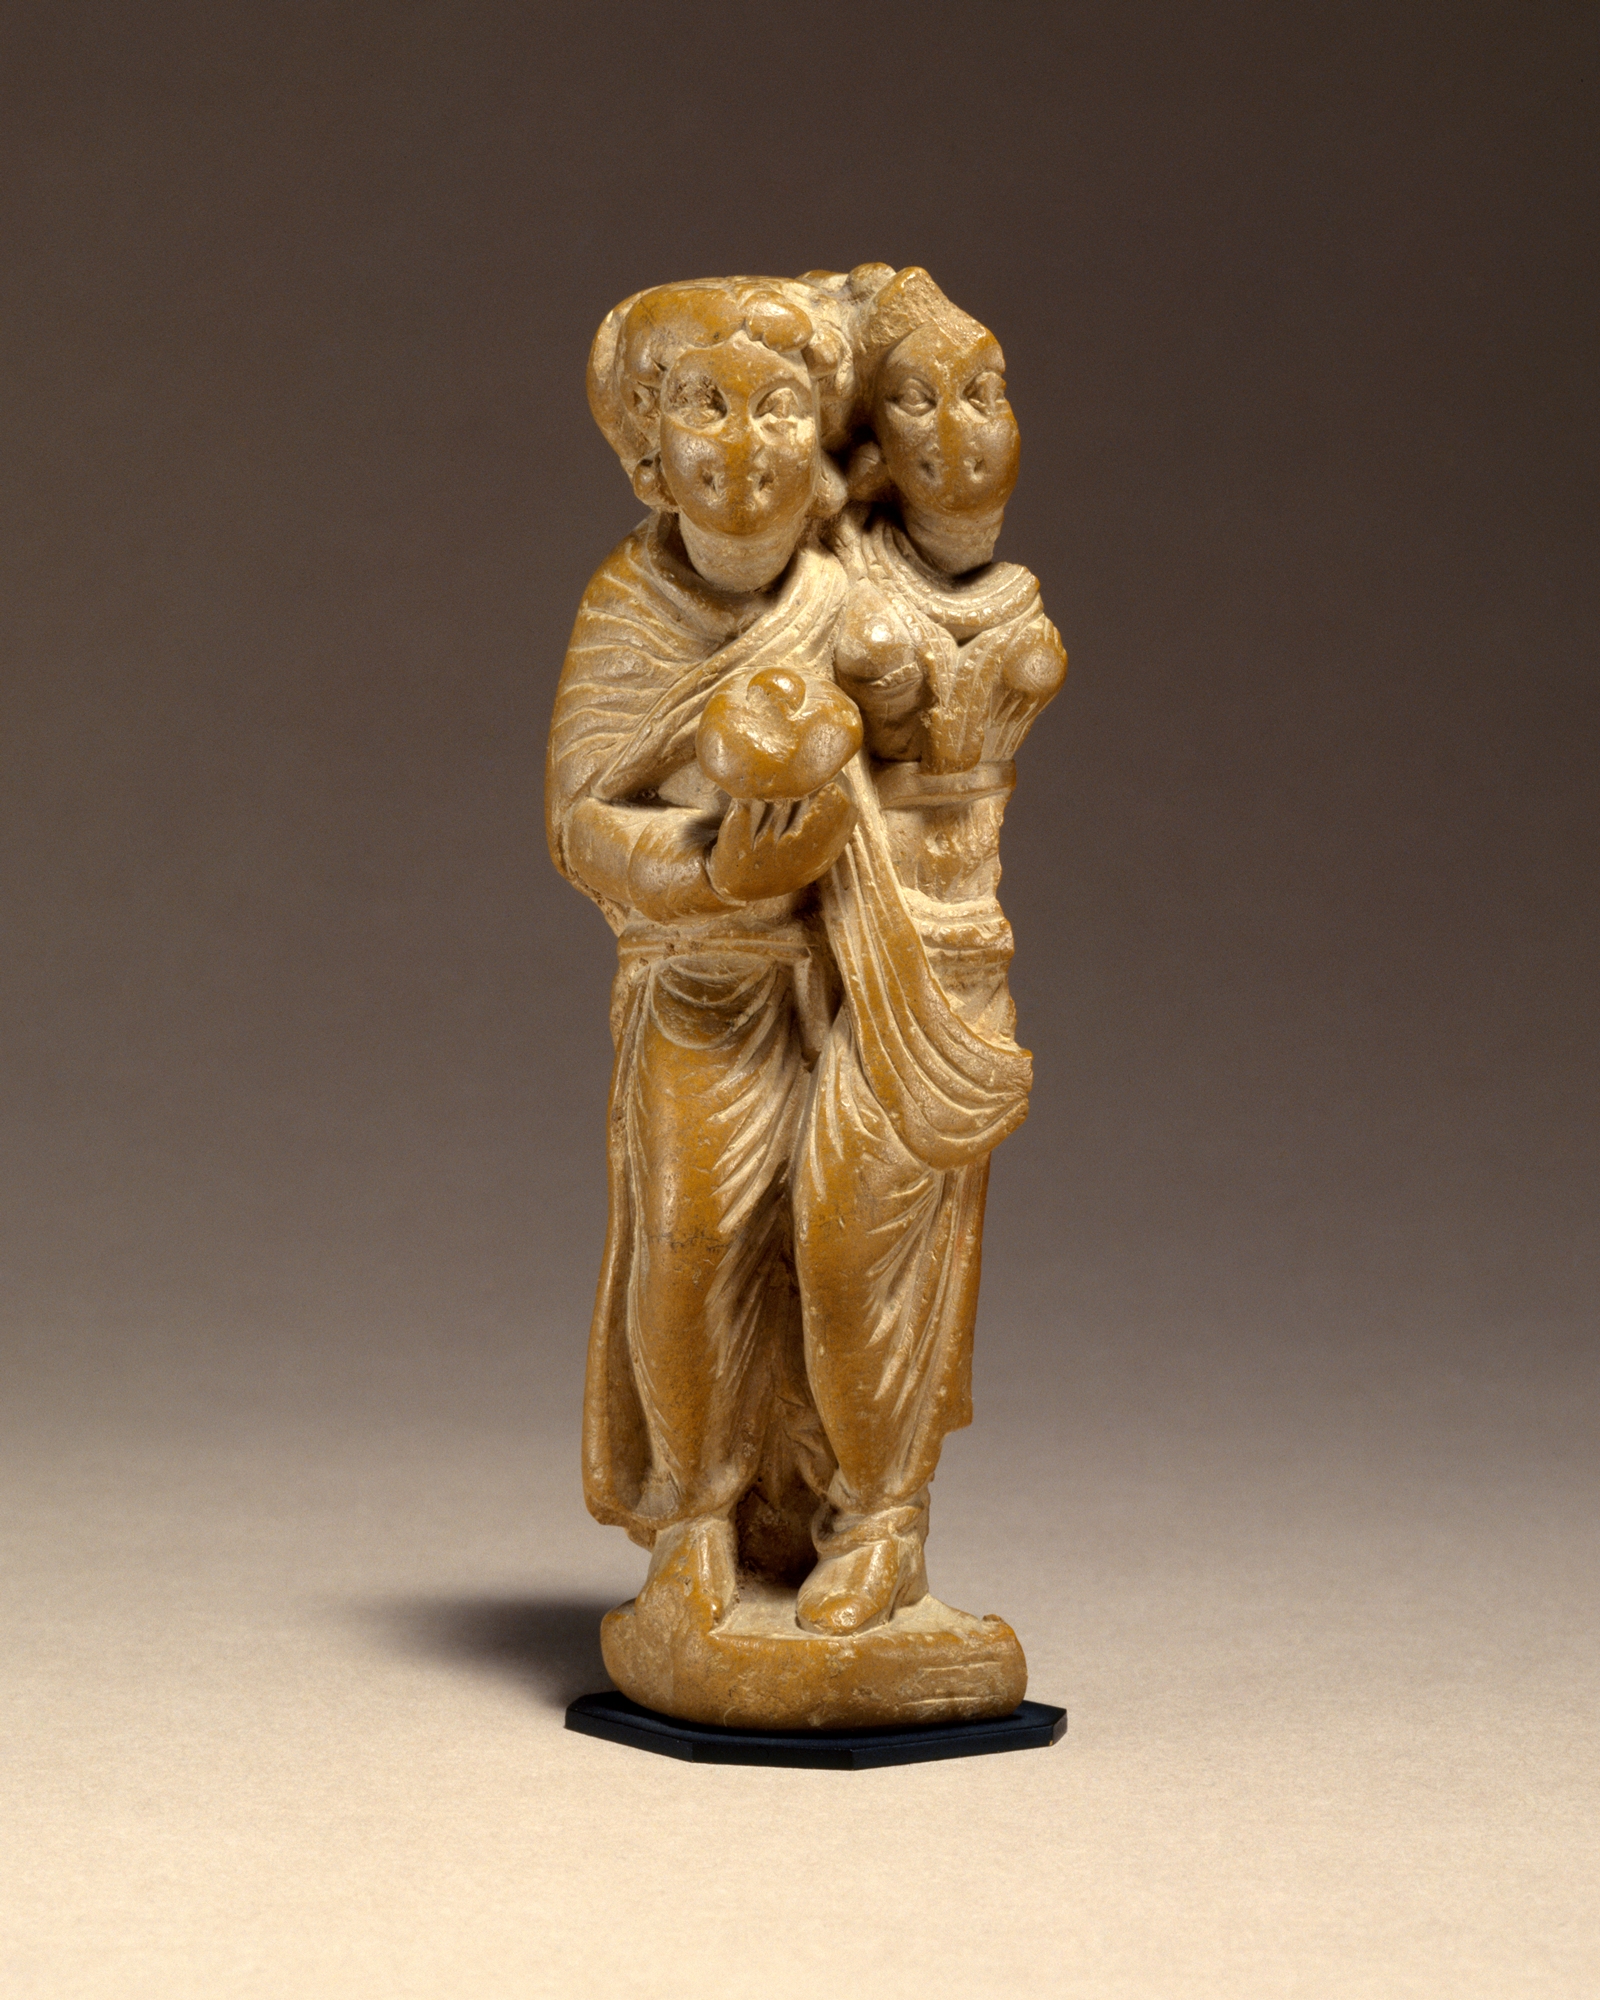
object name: mirror handle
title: Two Standing Women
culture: gandhara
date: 100-1 BCE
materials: stone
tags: kashmir,women